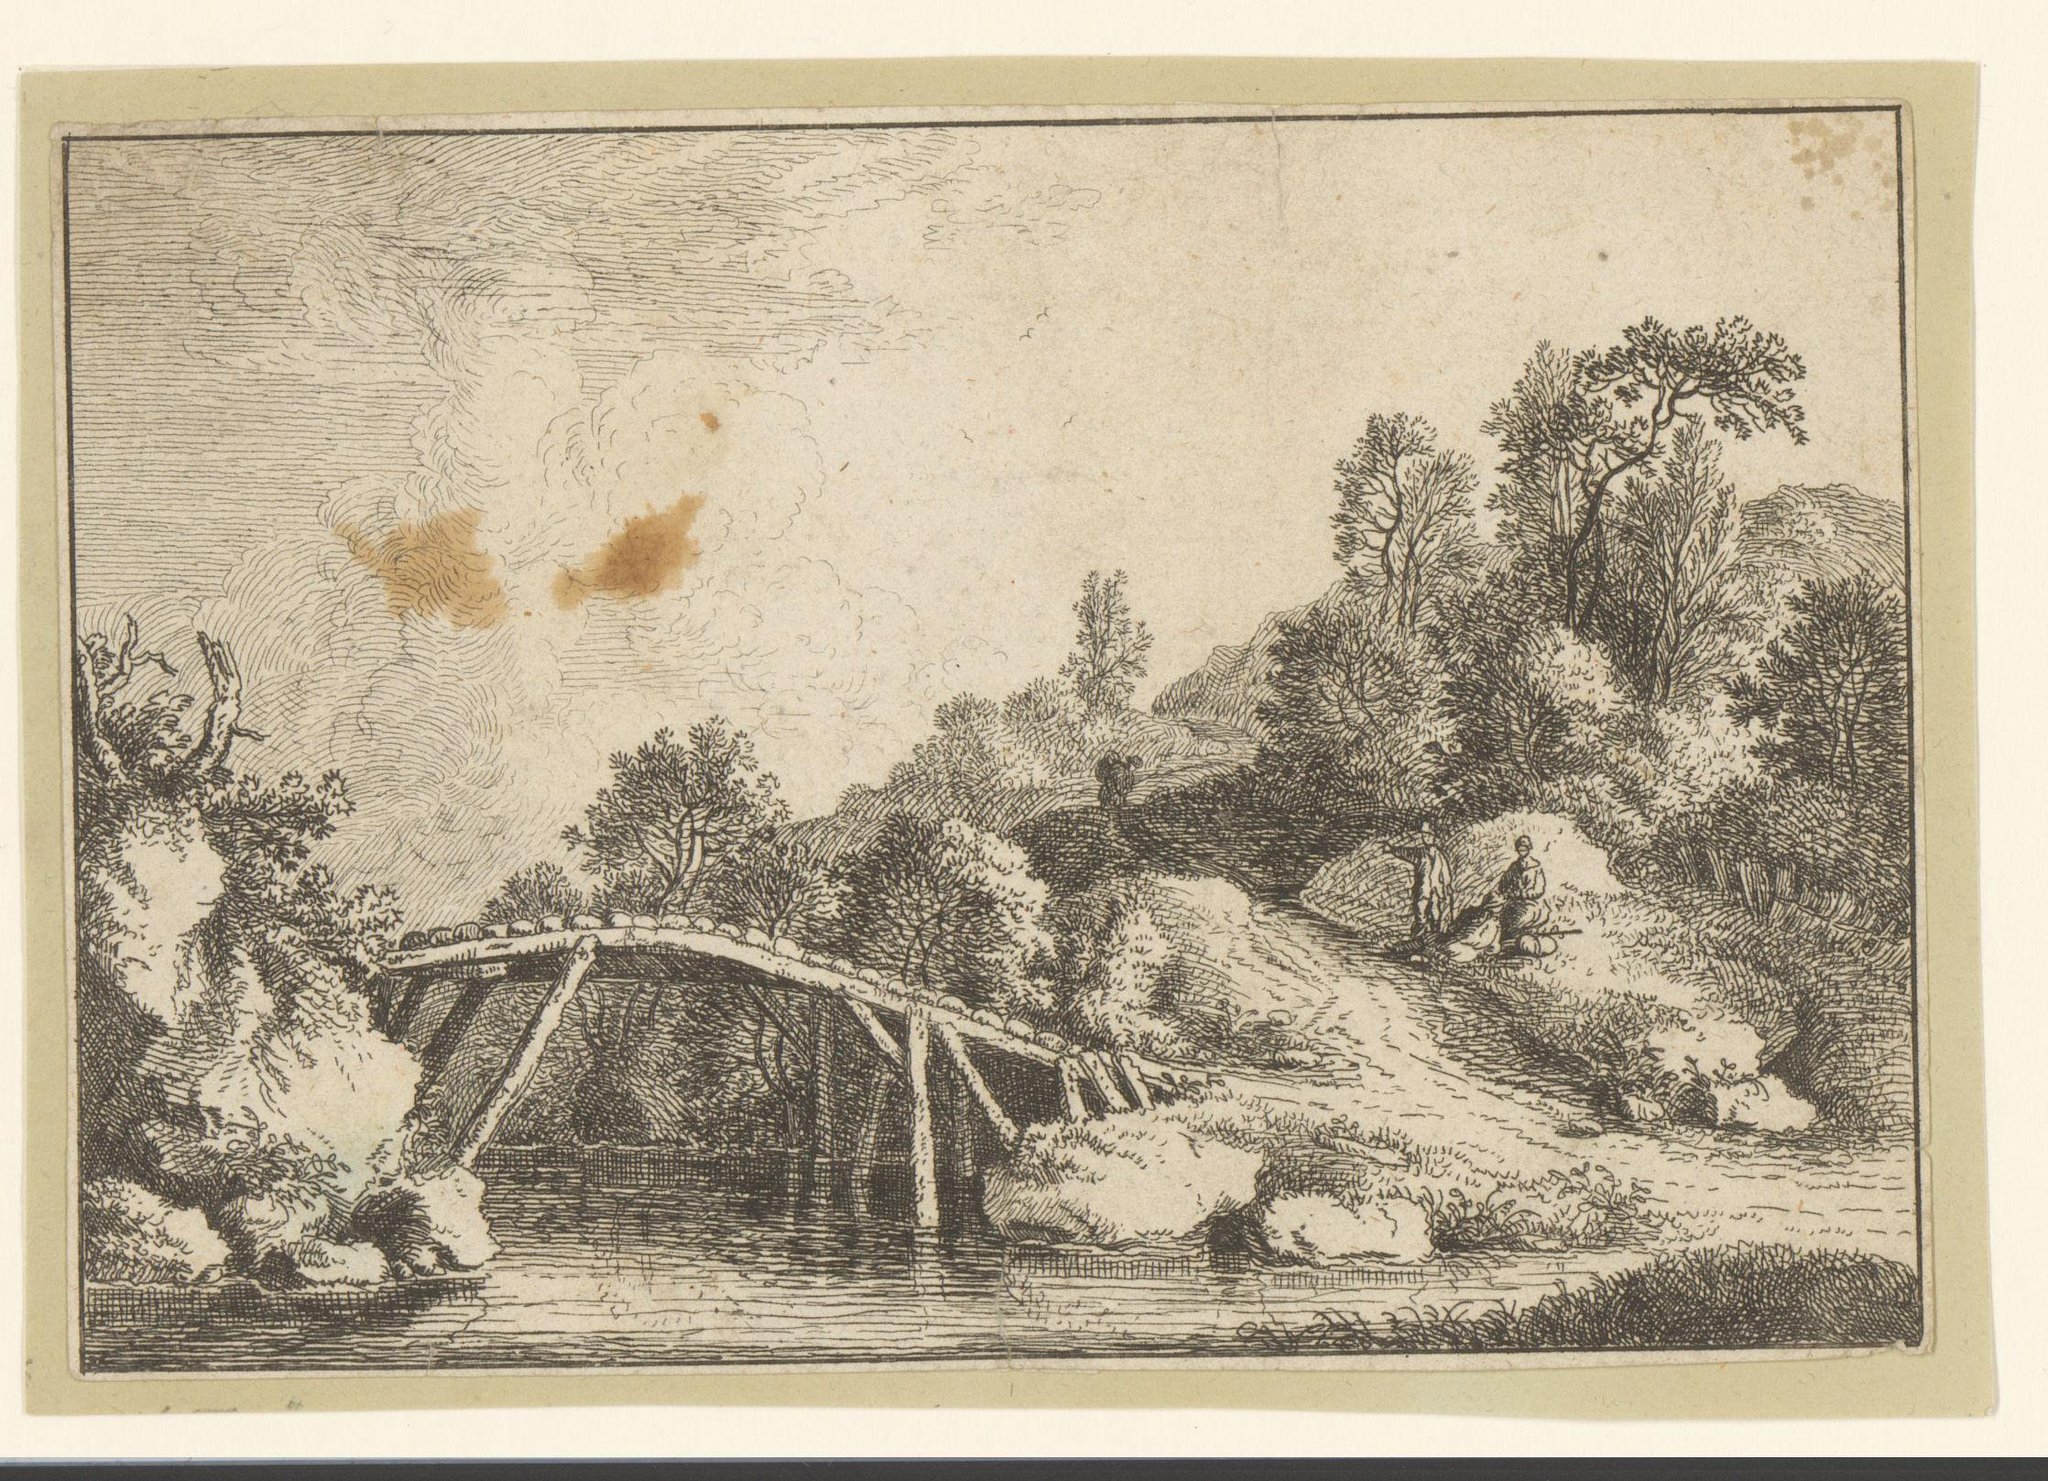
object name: print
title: Landschap met houten brug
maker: j. roemer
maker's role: print maker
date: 1600-1699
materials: paper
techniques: etching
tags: landscapes, landscape with bridge, viaduct or aqueduct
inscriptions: collector's mark: Lugt 2228